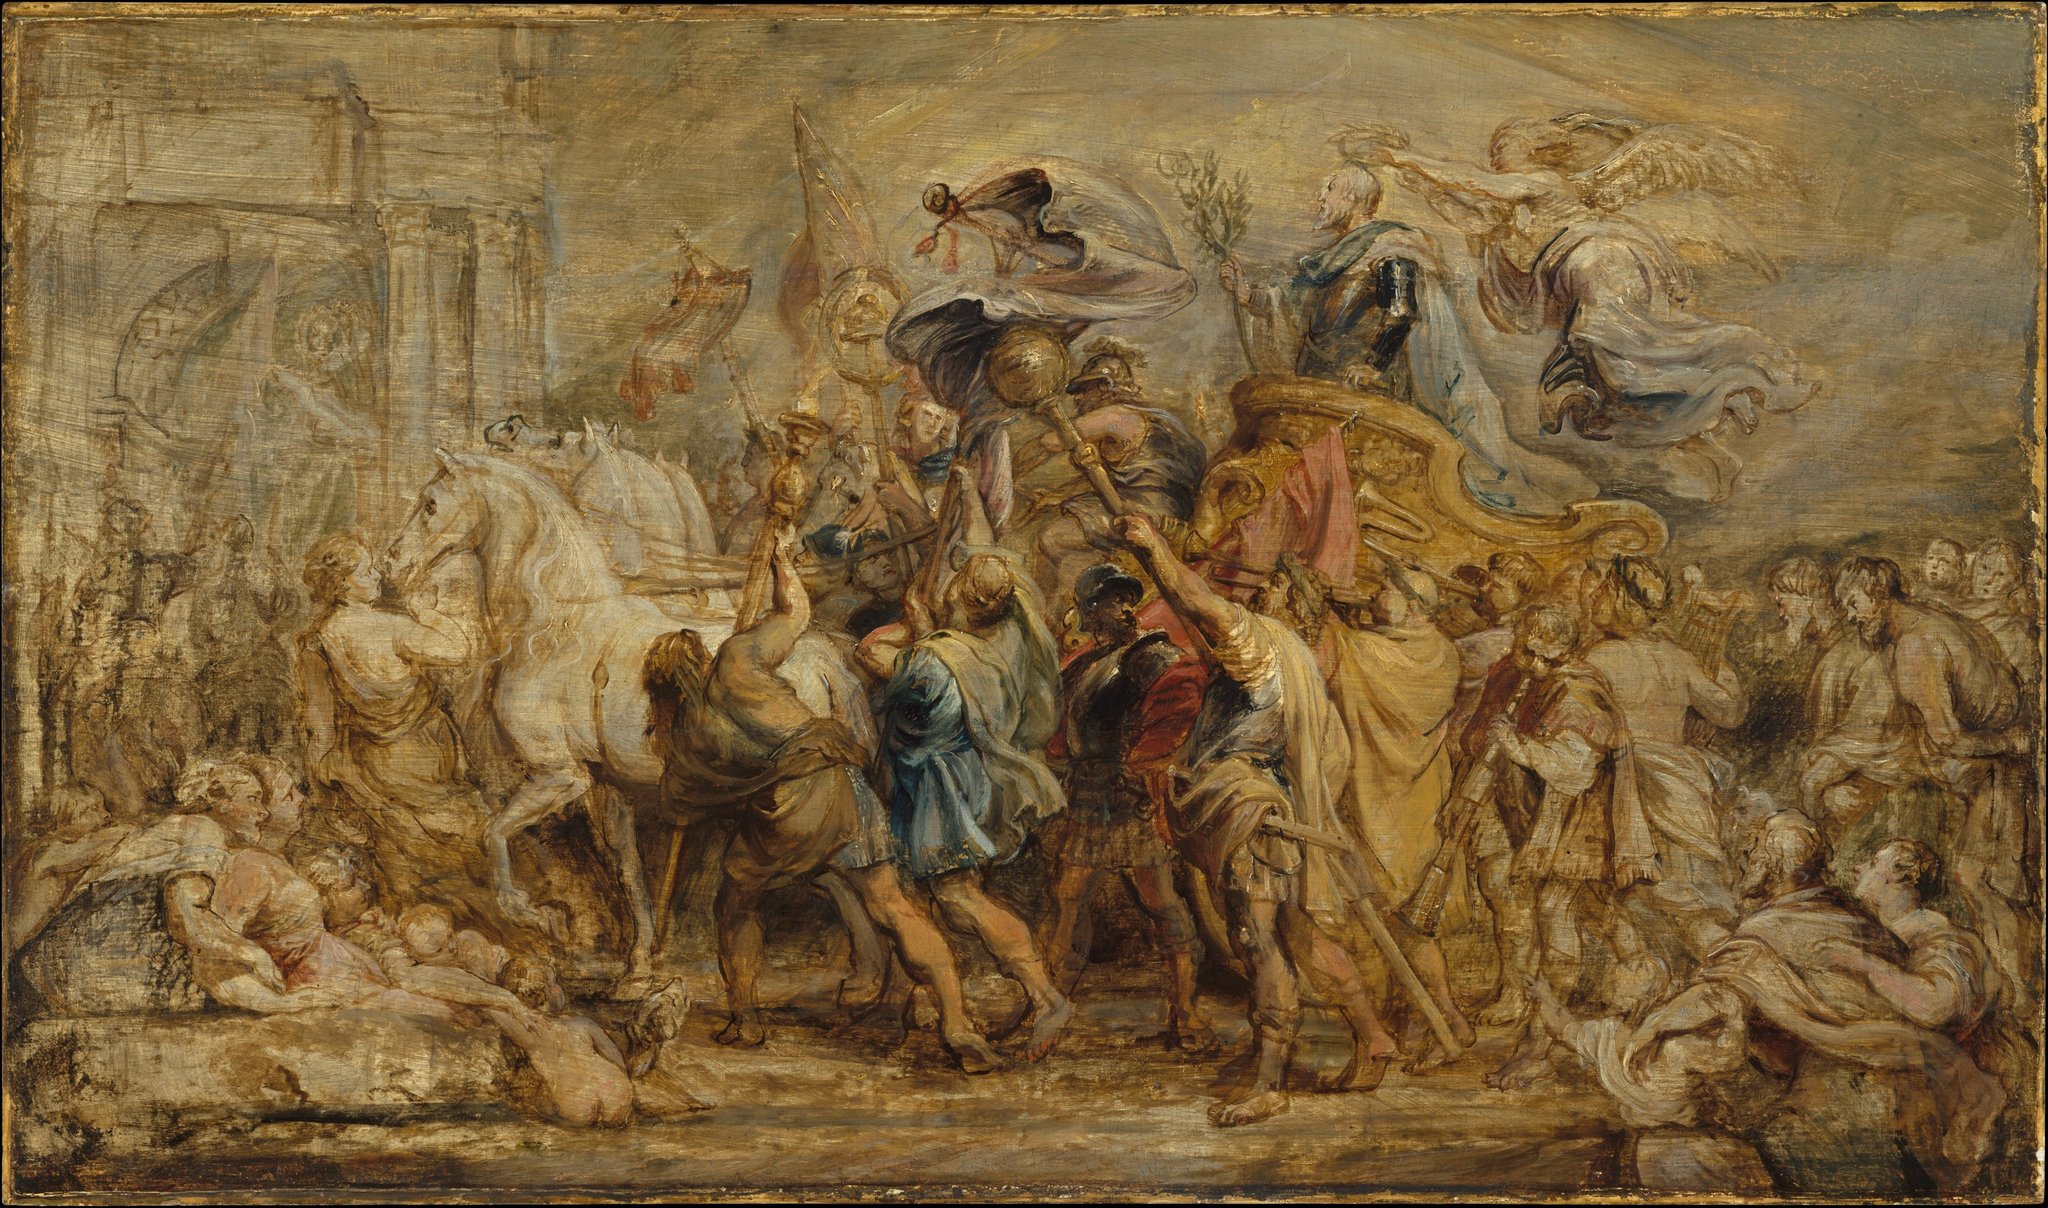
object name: painting, sketch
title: The Triumph of Henry IV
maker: peter paul rubens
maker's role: artist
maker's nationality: flemish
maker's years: 1577-1640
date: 1630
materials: oil, wood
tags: kings,men,women,horses,chariots